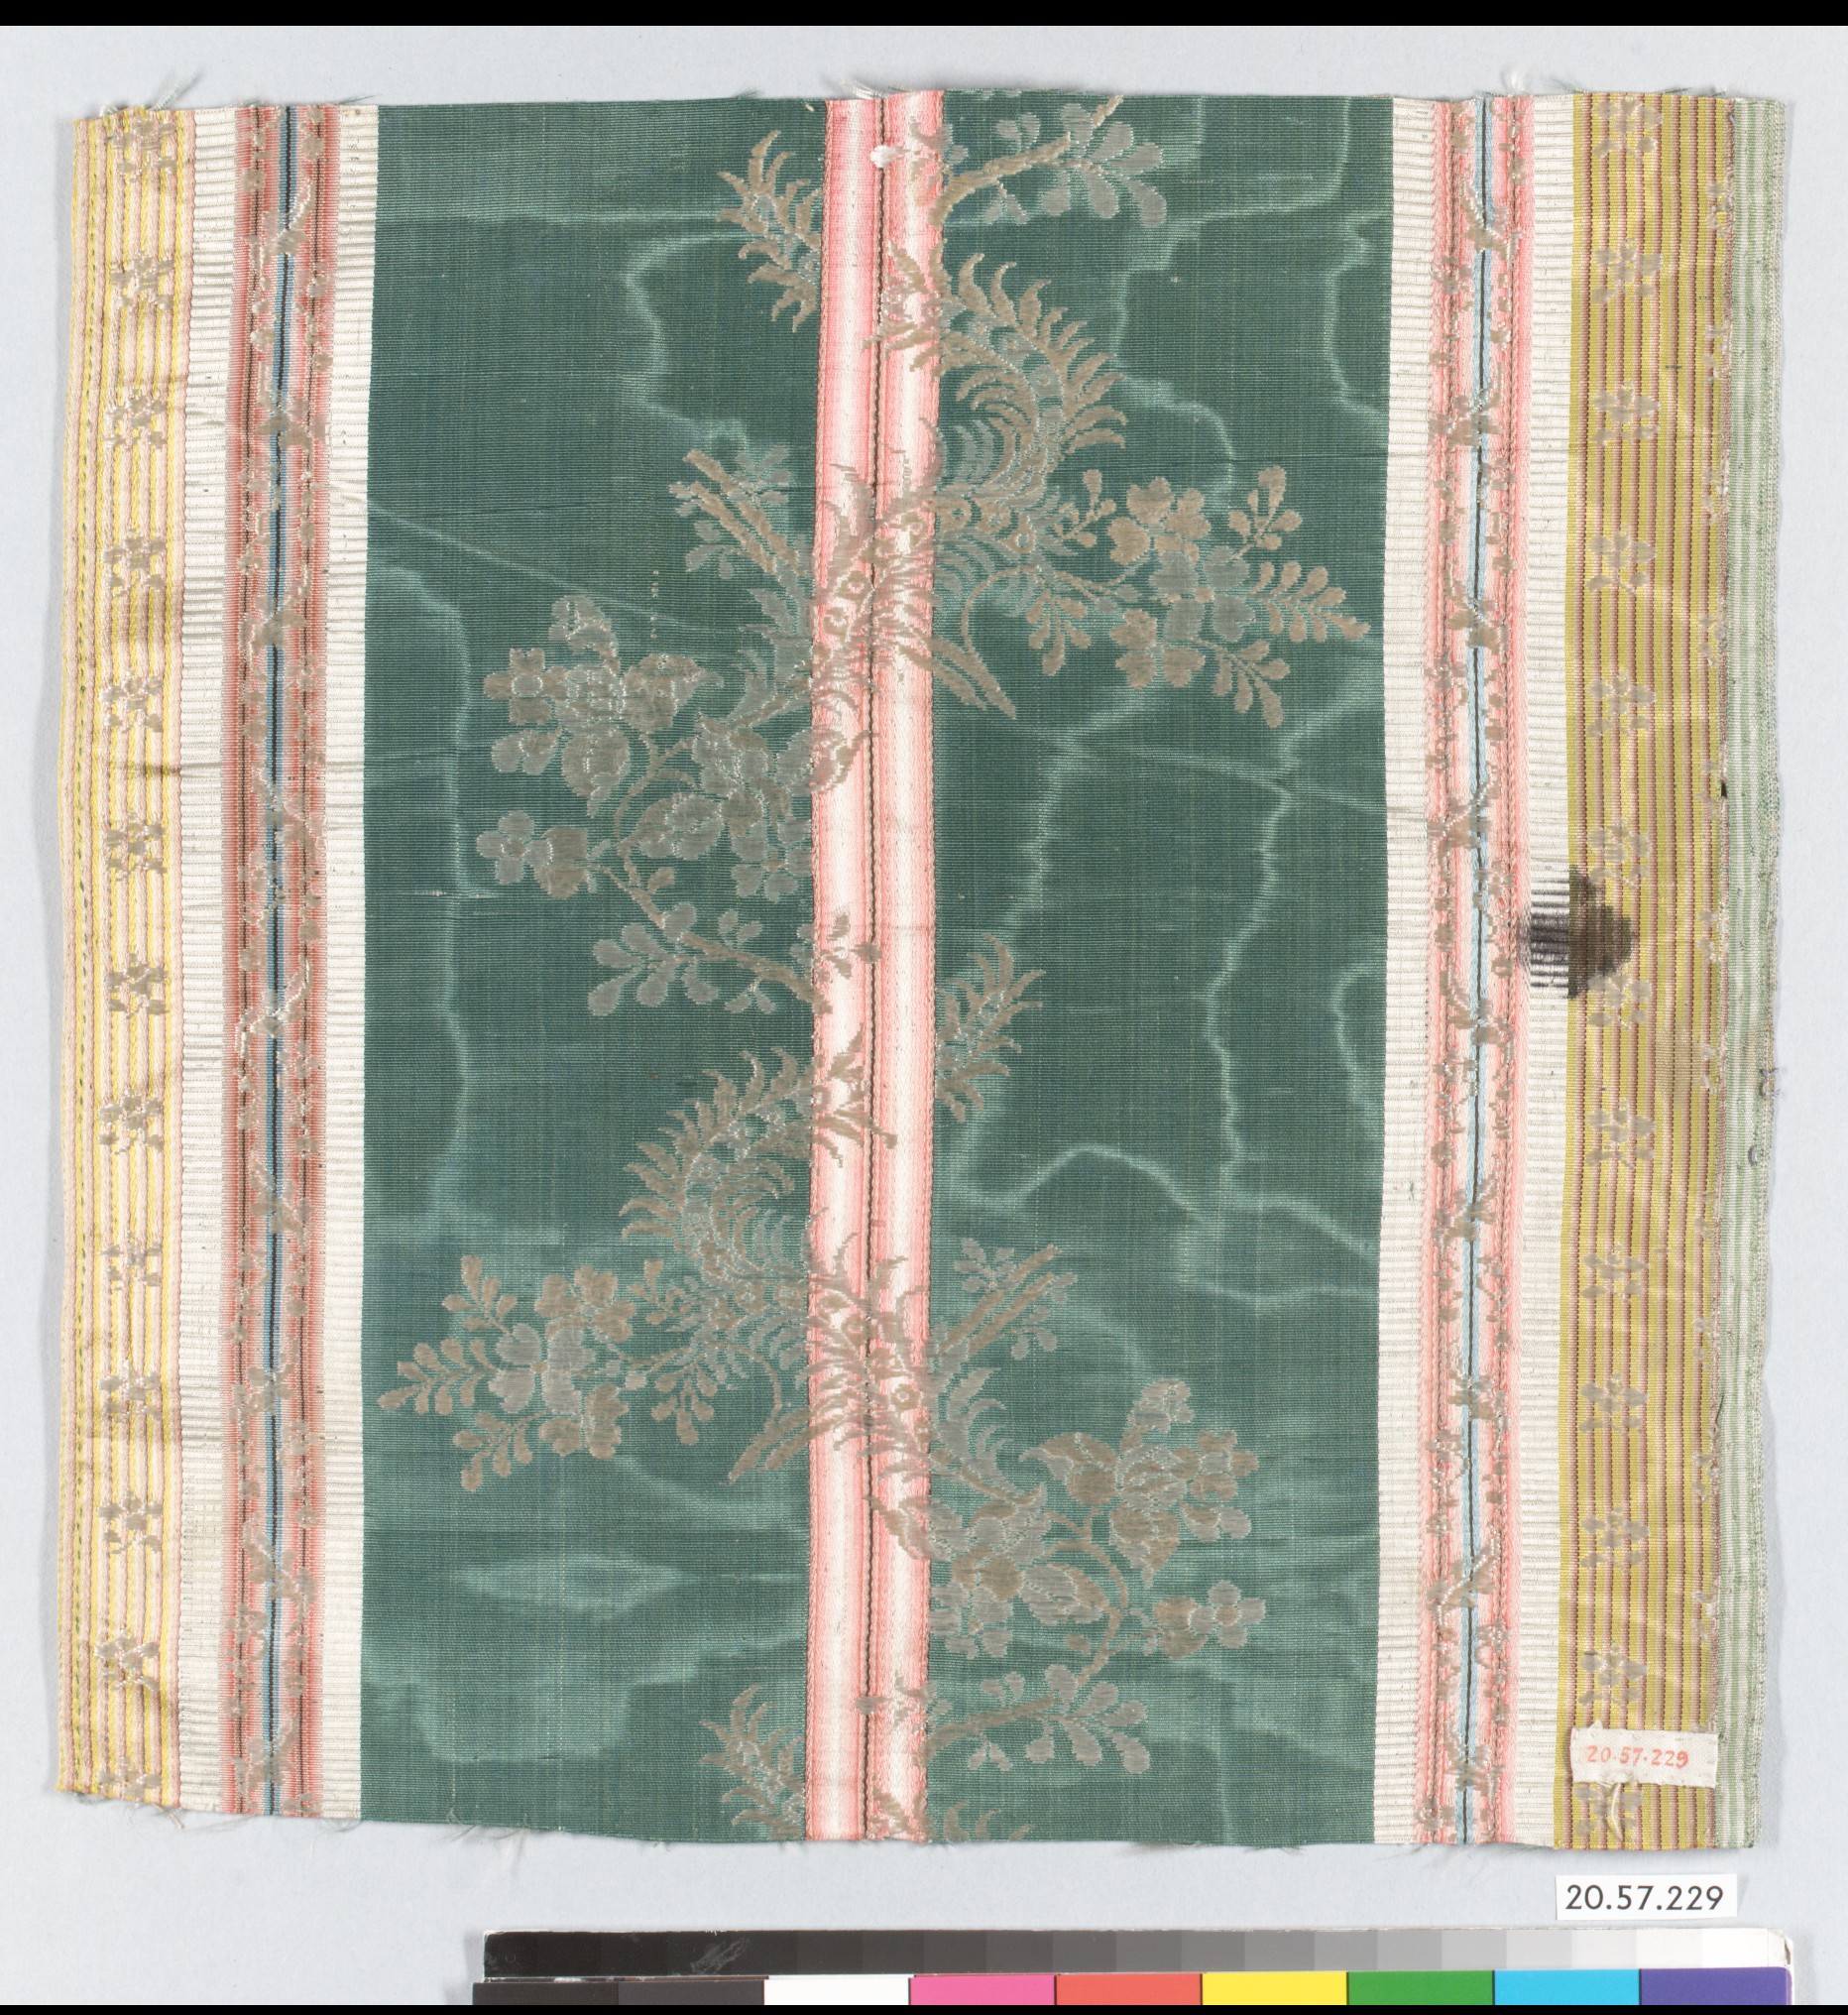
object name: piece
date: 1775-1800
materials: silk